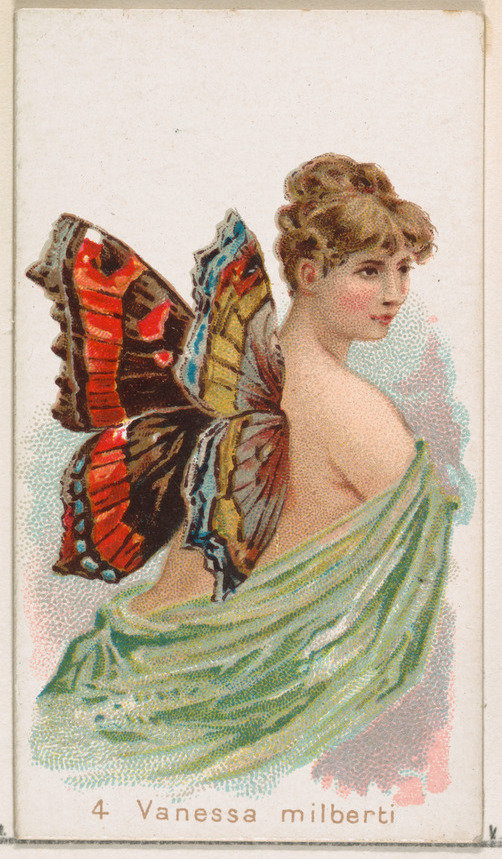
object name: print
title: Card 4, Vanessa Milberti, from the Butterflies series (N183) issued by Wm. S. Kimball & Co.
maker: william s. kimball & company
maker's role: publisher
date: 1888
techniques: color lithograph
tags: women,butterflies